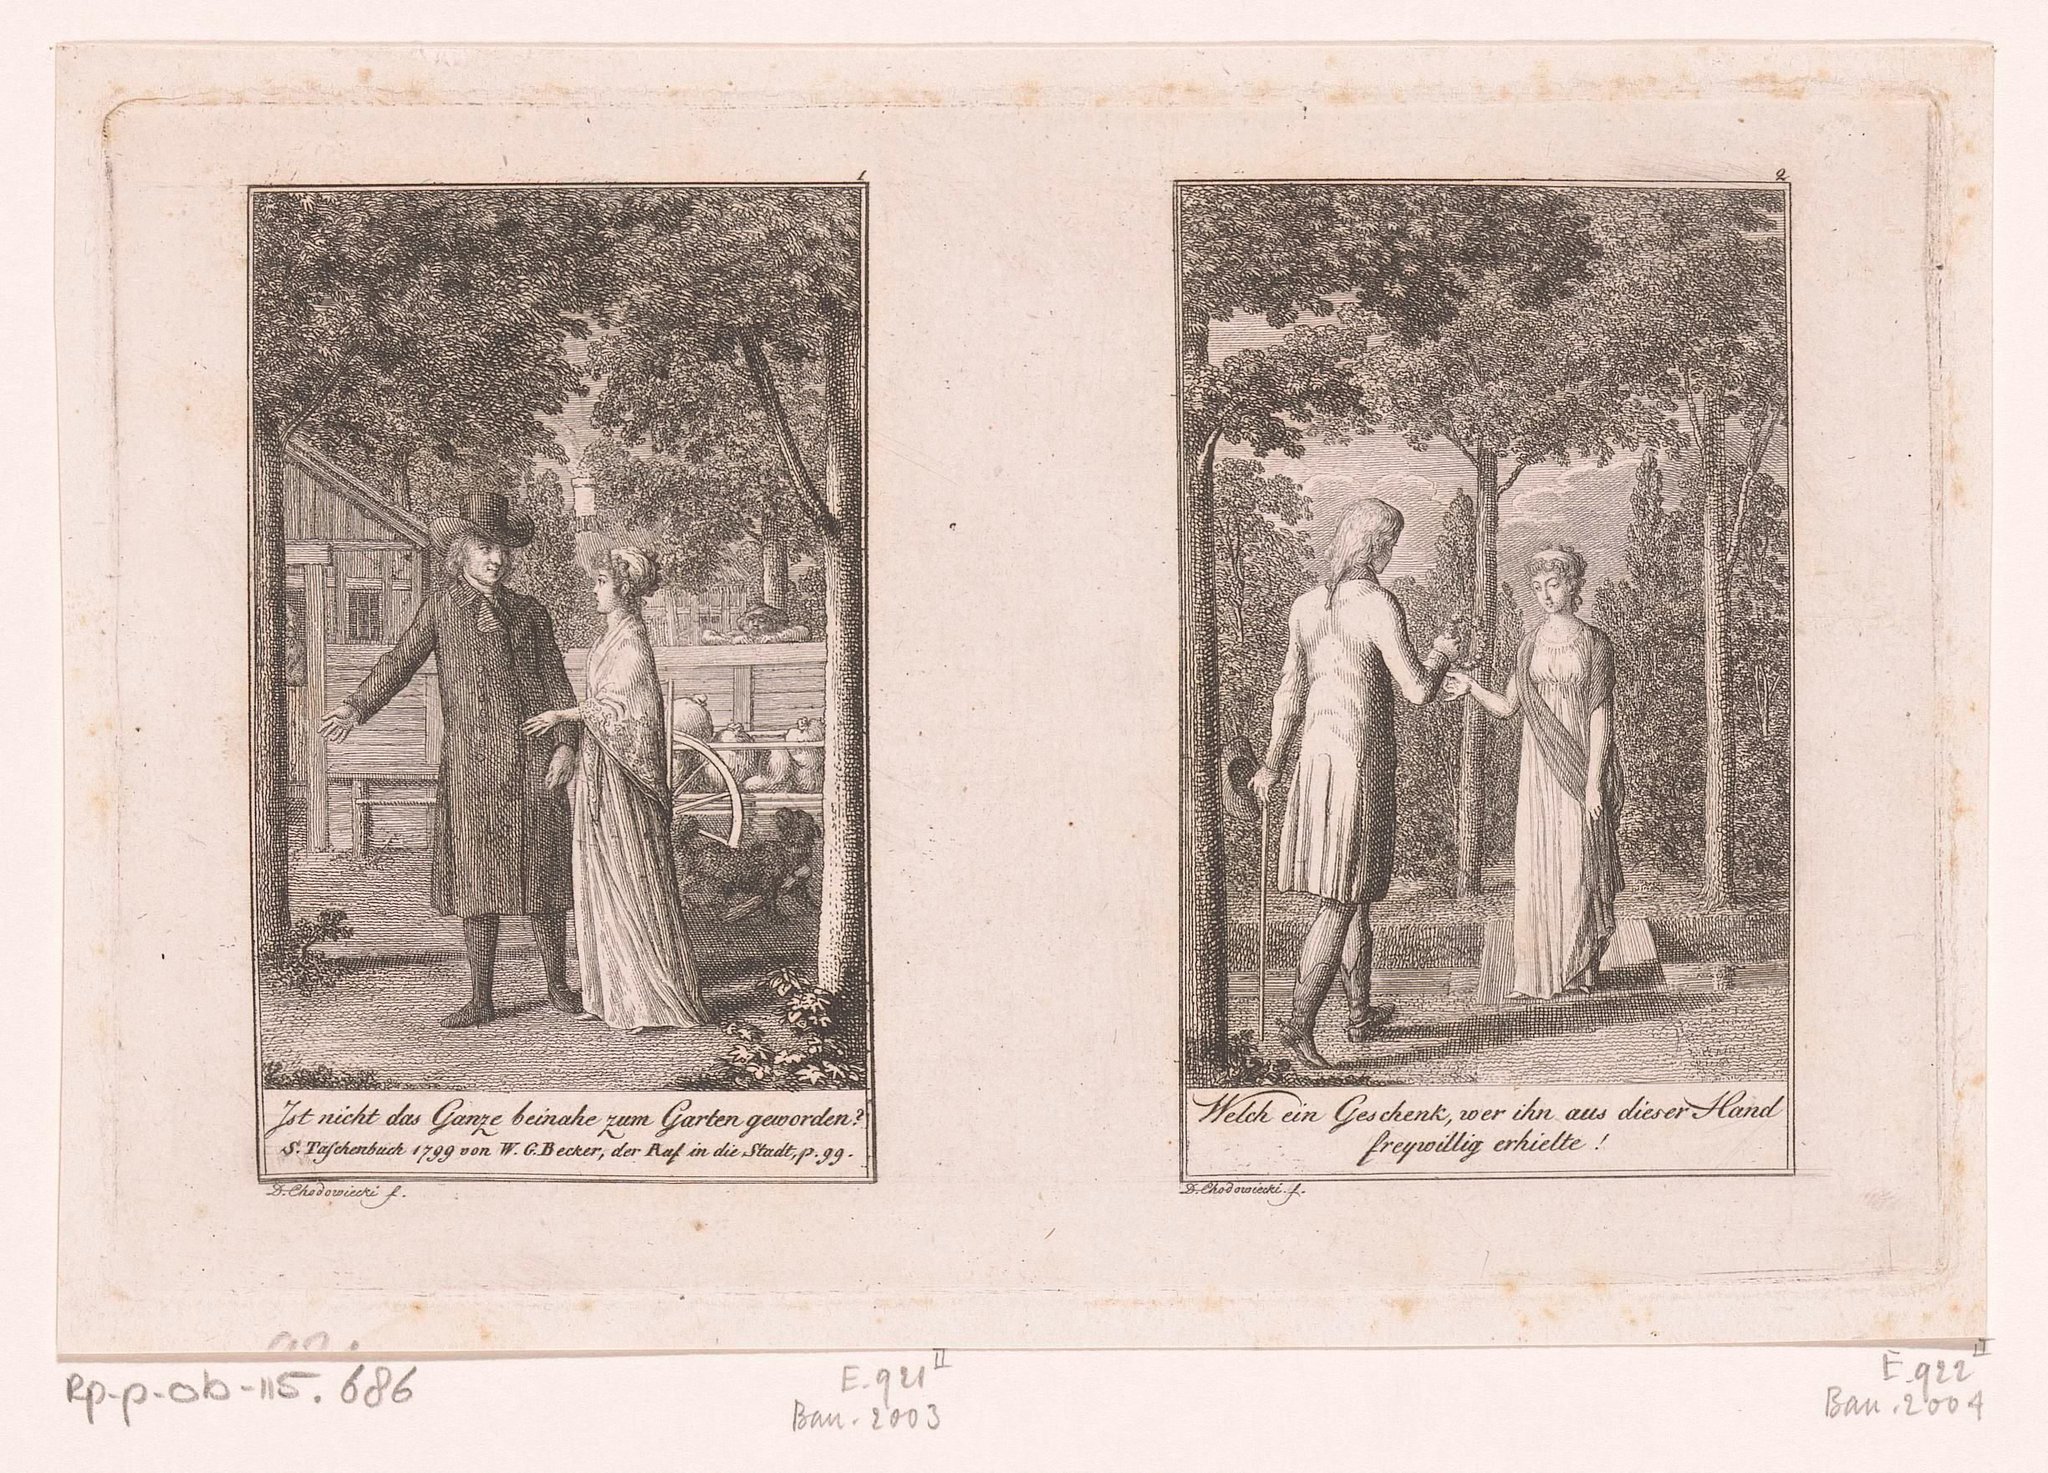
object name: print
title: Twee voorstellingen uit de verhalen van Wilhelm Gottlieb Becker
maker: daniel nikolaus chodowiecki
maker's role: draughtsman, print maker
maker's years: 1726-1801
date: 1800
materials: paper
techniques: etching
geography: berlin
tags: gifts being accepted, garland, wreath, garden, functionaries and dignitaries ~ protestant churches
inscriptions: collector's mark: Lugt 2228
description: Prenten gebruikt voor: Becker, Wilhelm Gottlieb. W. G. Becker's Taschenbuch zum geselligen Vergnügen. Leipzig: Roch und Comp, 1801.